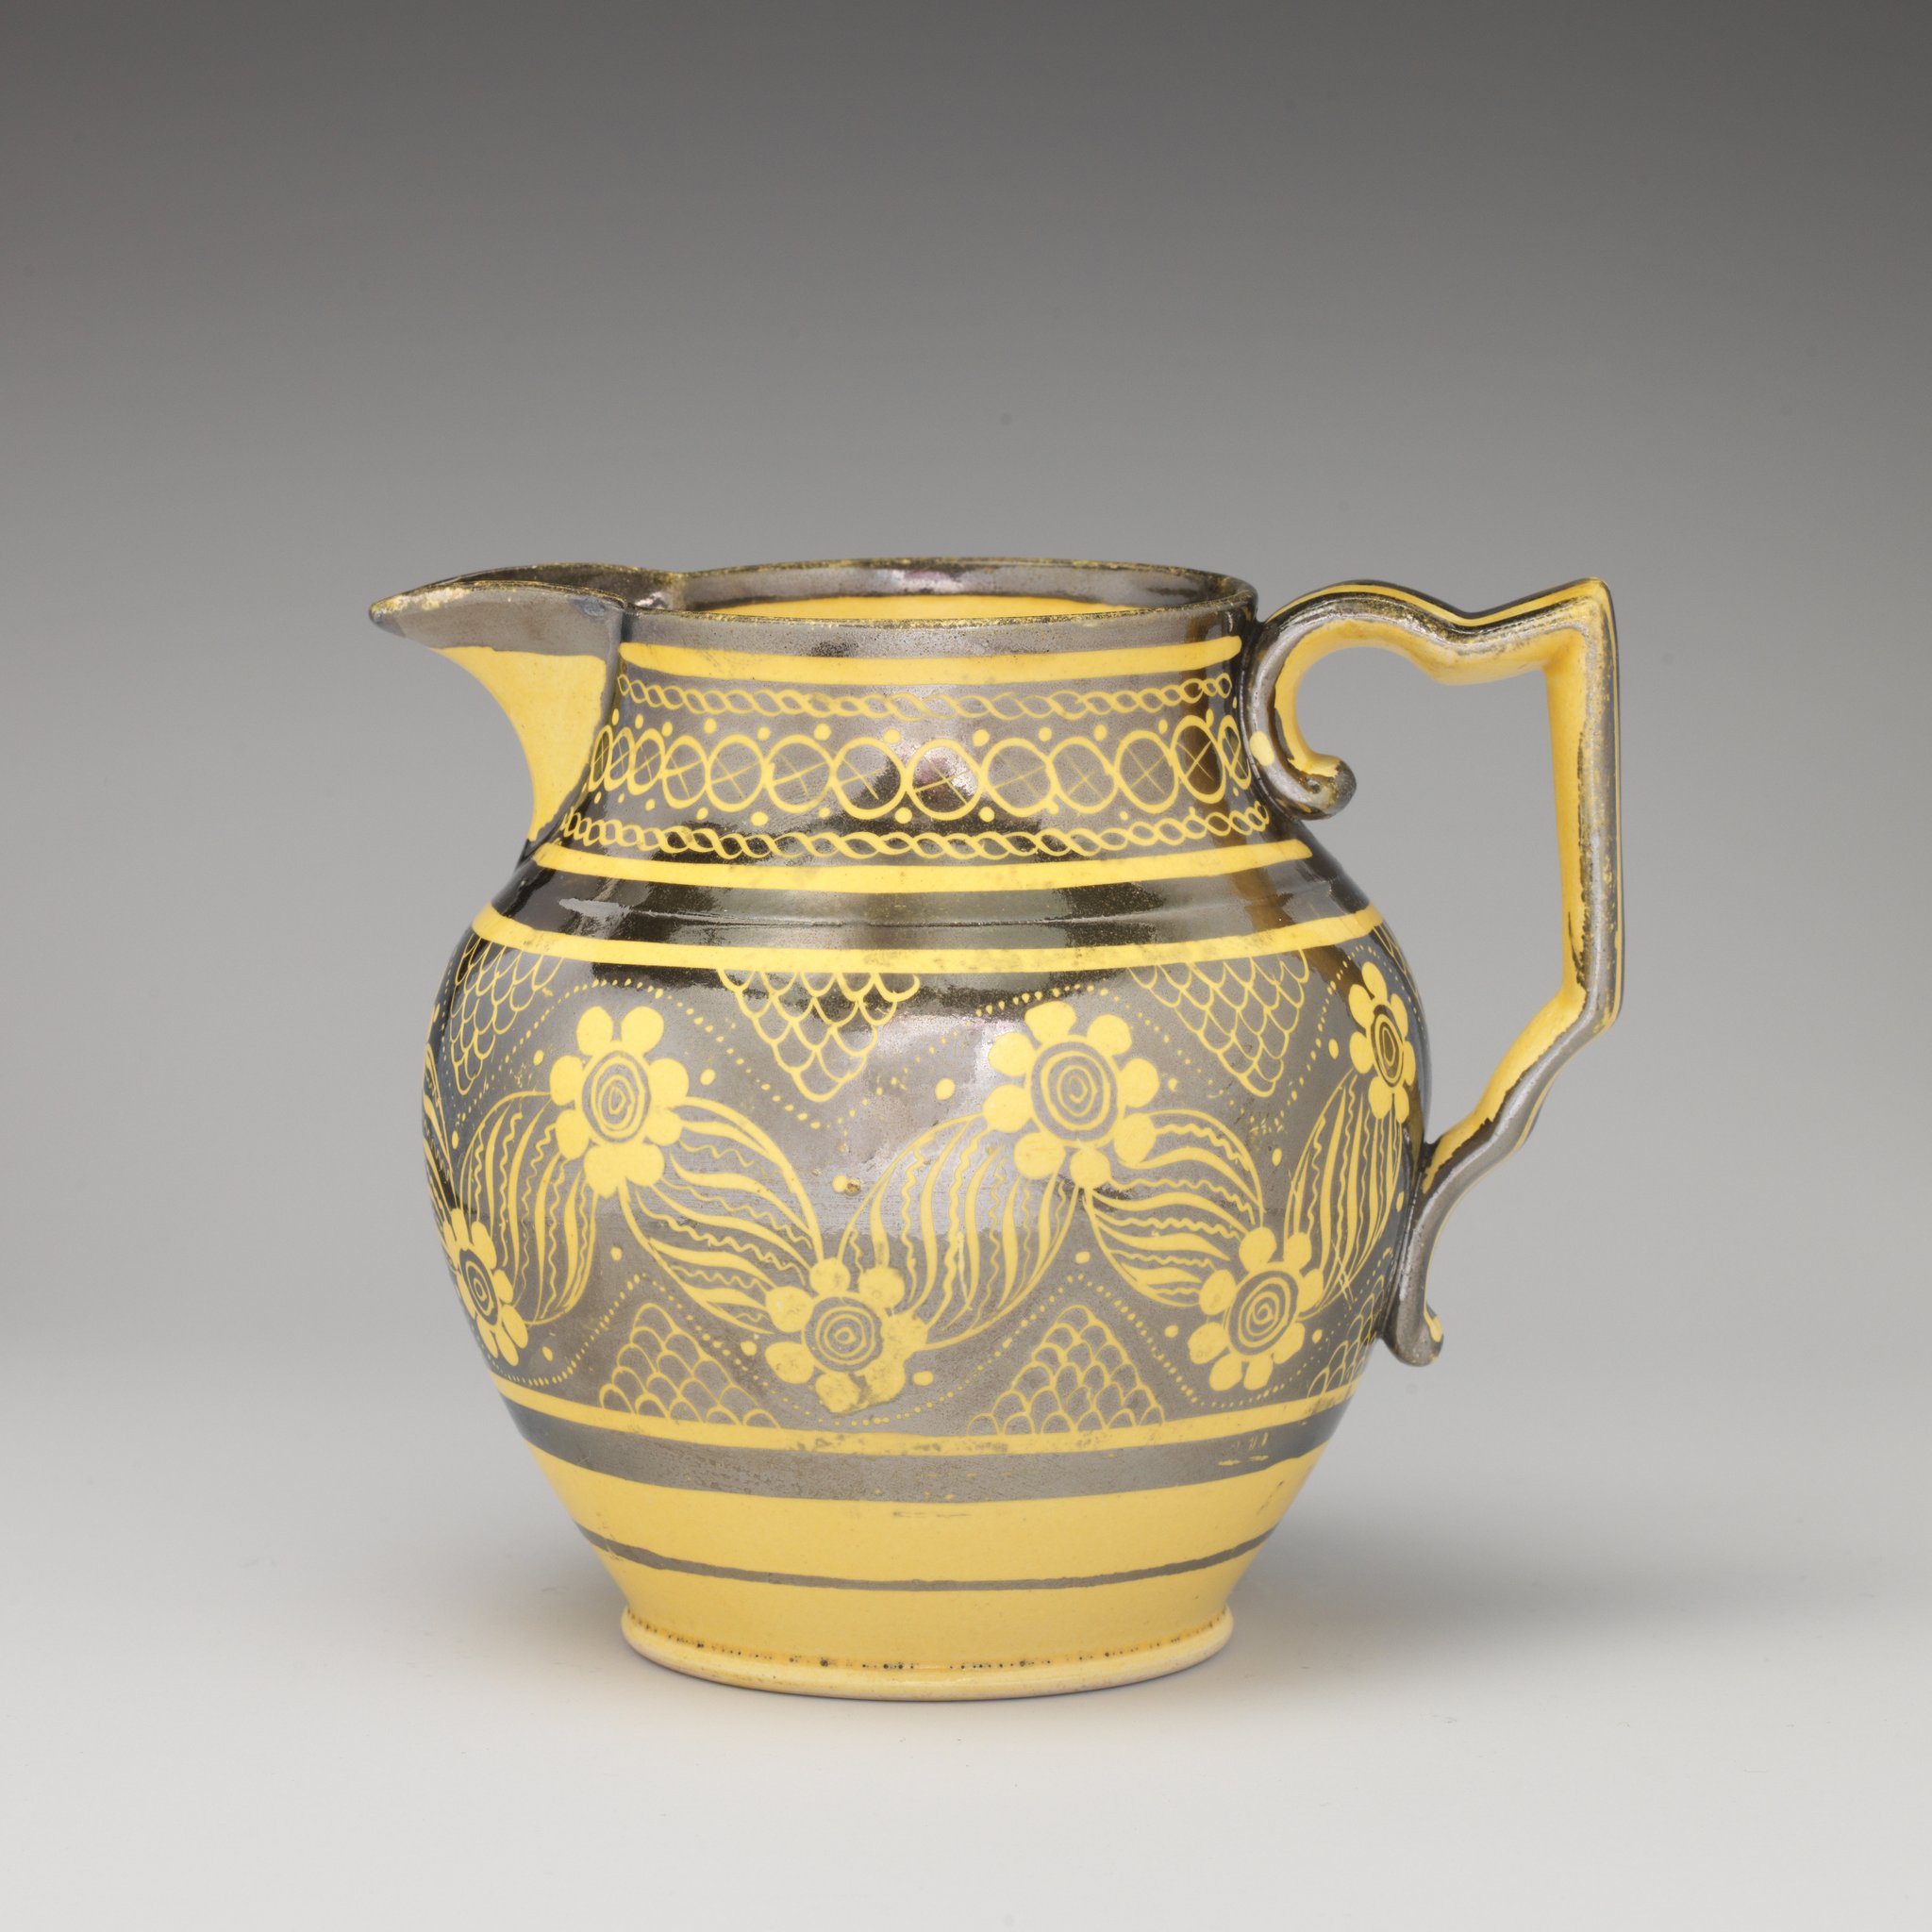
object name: jug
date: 1815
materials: creamware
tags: flowers